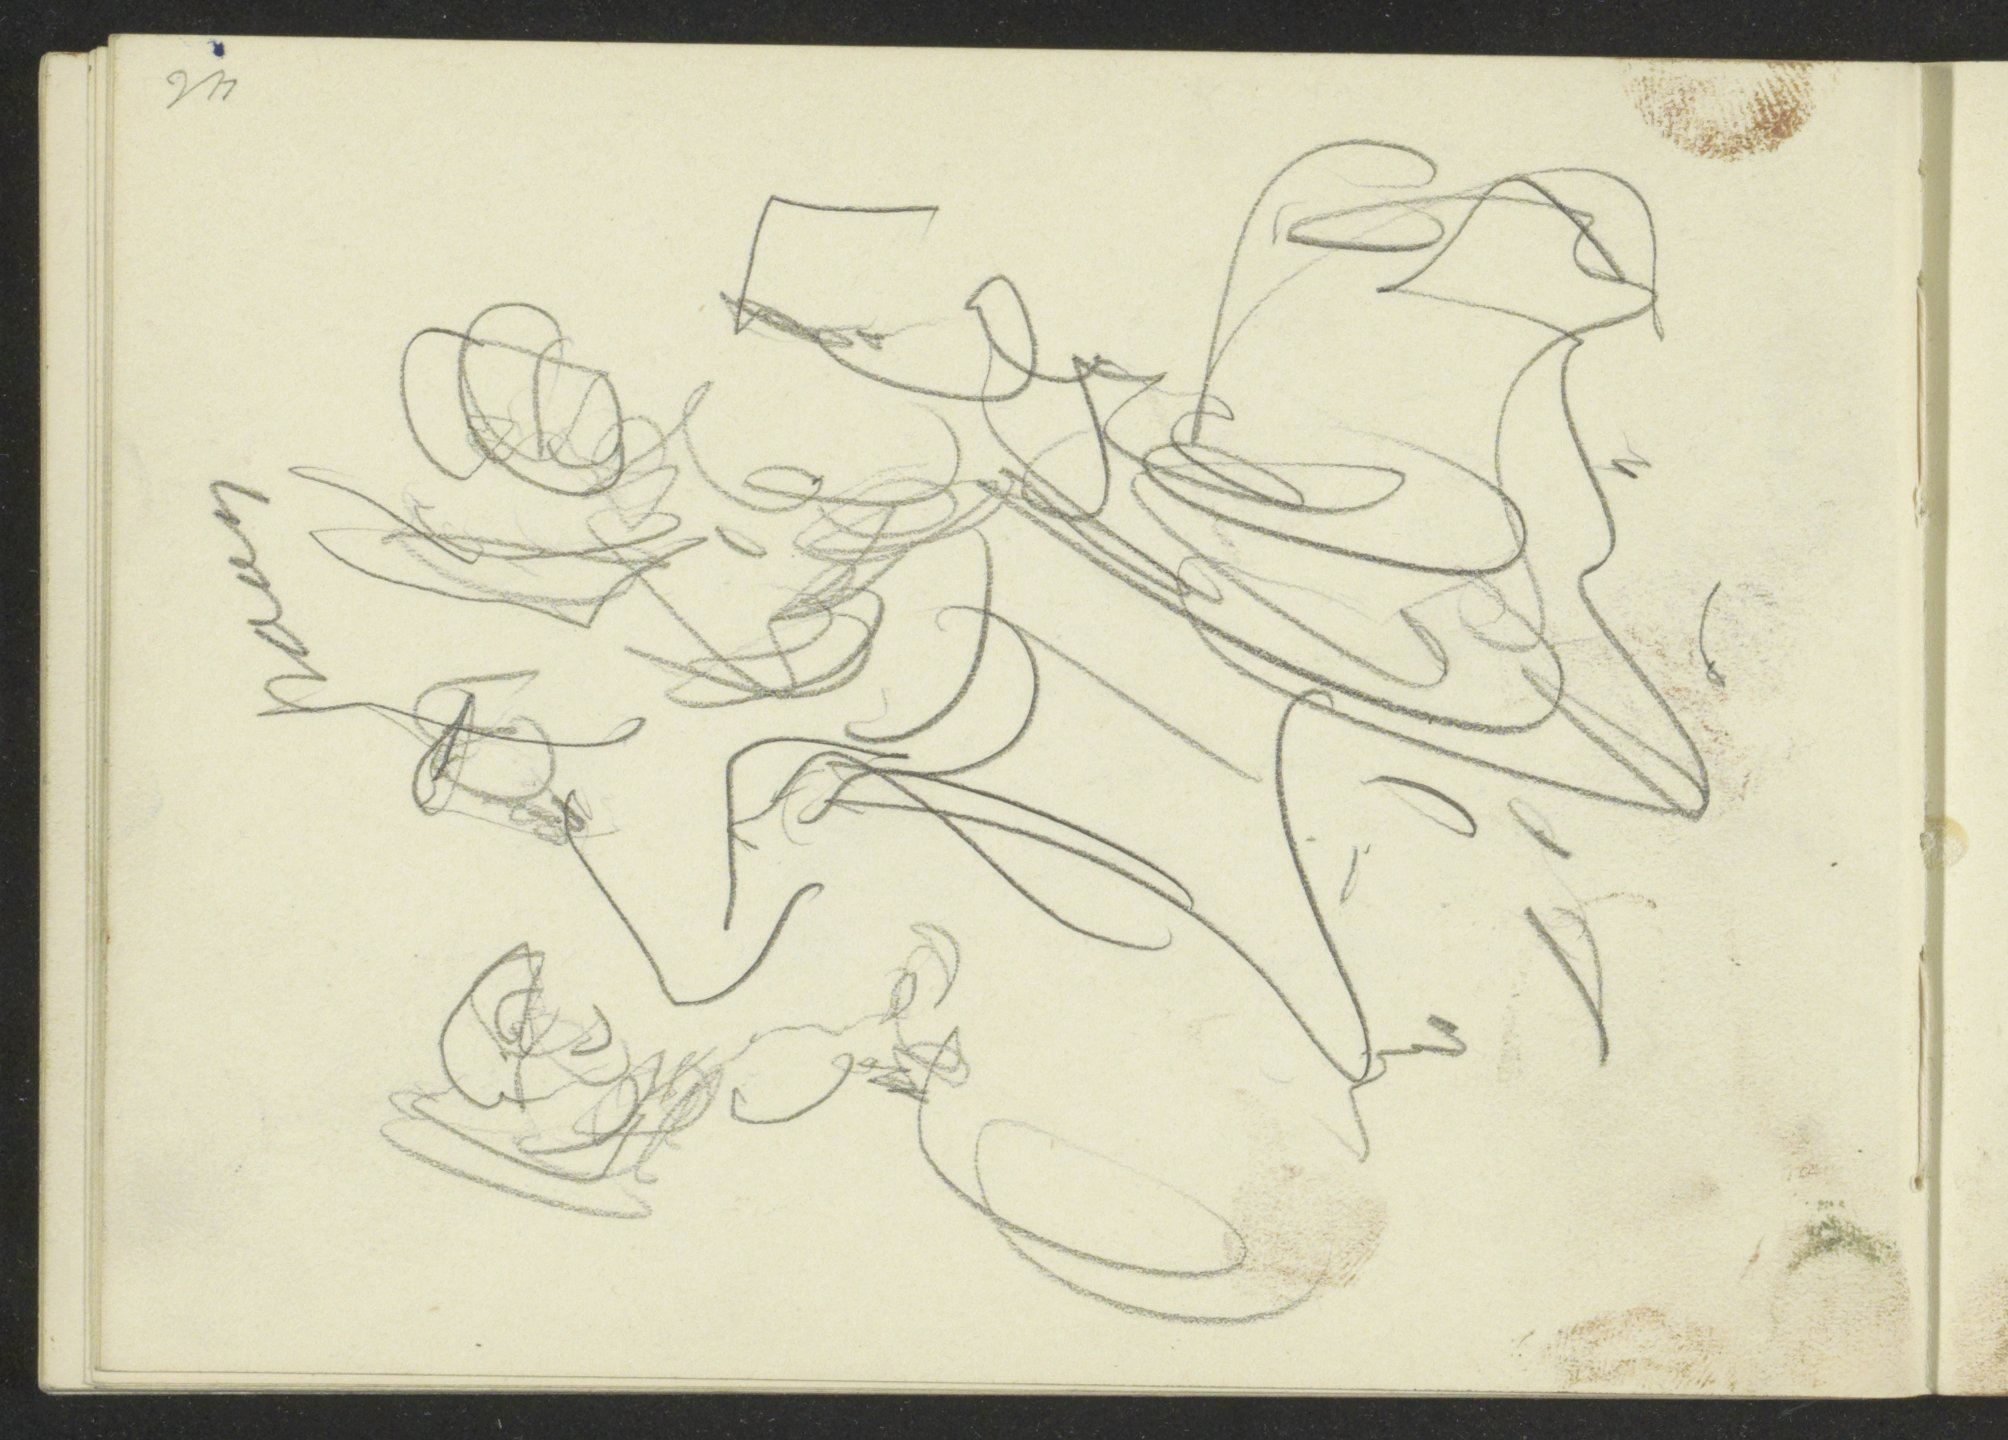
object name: sketchbook leaf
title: Drie vrouwen, mogelijk dansend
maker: isaac israels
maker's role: draughtsman, painter, print maker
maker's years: 1865-1934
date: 1875-1934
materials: paper, pencil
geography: the hague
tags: adult woman, group dancing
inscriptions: annotation: ‘[...]’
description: Blad 13 verso uit schetsboek LVII met 29 bladen.